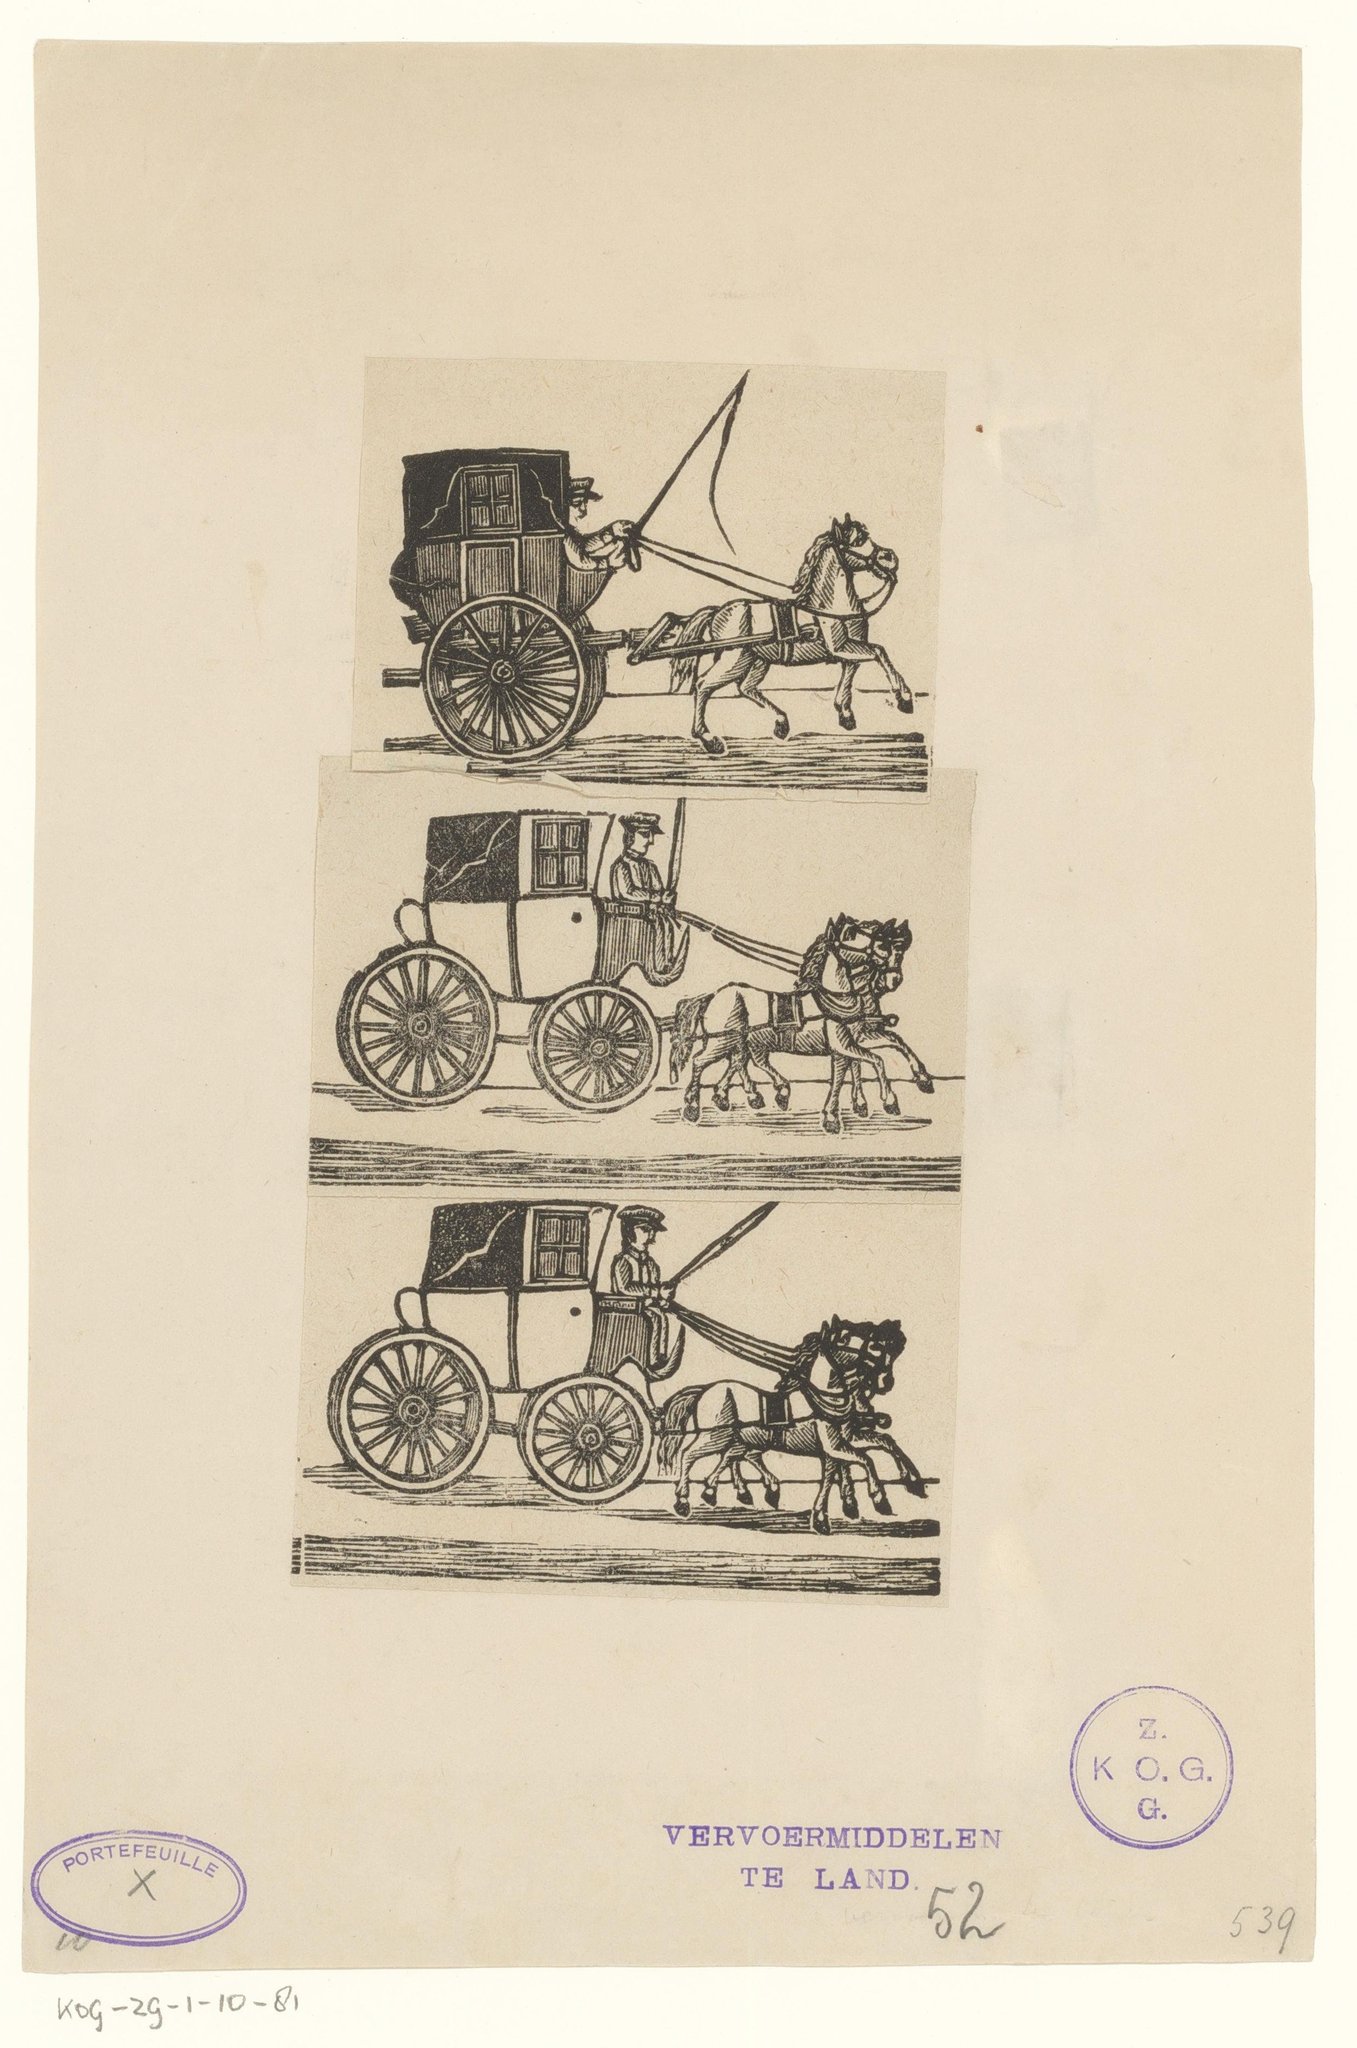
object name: popular print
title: Drie rijtuigen getrokken door paarden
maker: Anonymous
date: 1856-1900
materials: paper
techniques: letterpress printing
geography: turnhout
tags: four-wheeled, animal-drawn vehicle, e.g.: cab, carriage, coach, two-wheeled vehicle drawn by one animal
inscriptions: stamp, collector's mark: Lugt 1641, stamp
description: Drie losse prenten op een opzetvel van drie rijtuigen getrokken door paarden. Waarschijnlijk zijn alle drie afkomstig van dezelfde volksprent. Onderwerpsrubrieken binnen de Atlas Zeden en Gewoonten: Vervoermiddelen te land en te water, Vervoermiddelen te land, Rijtuigen en Statiekarossen.